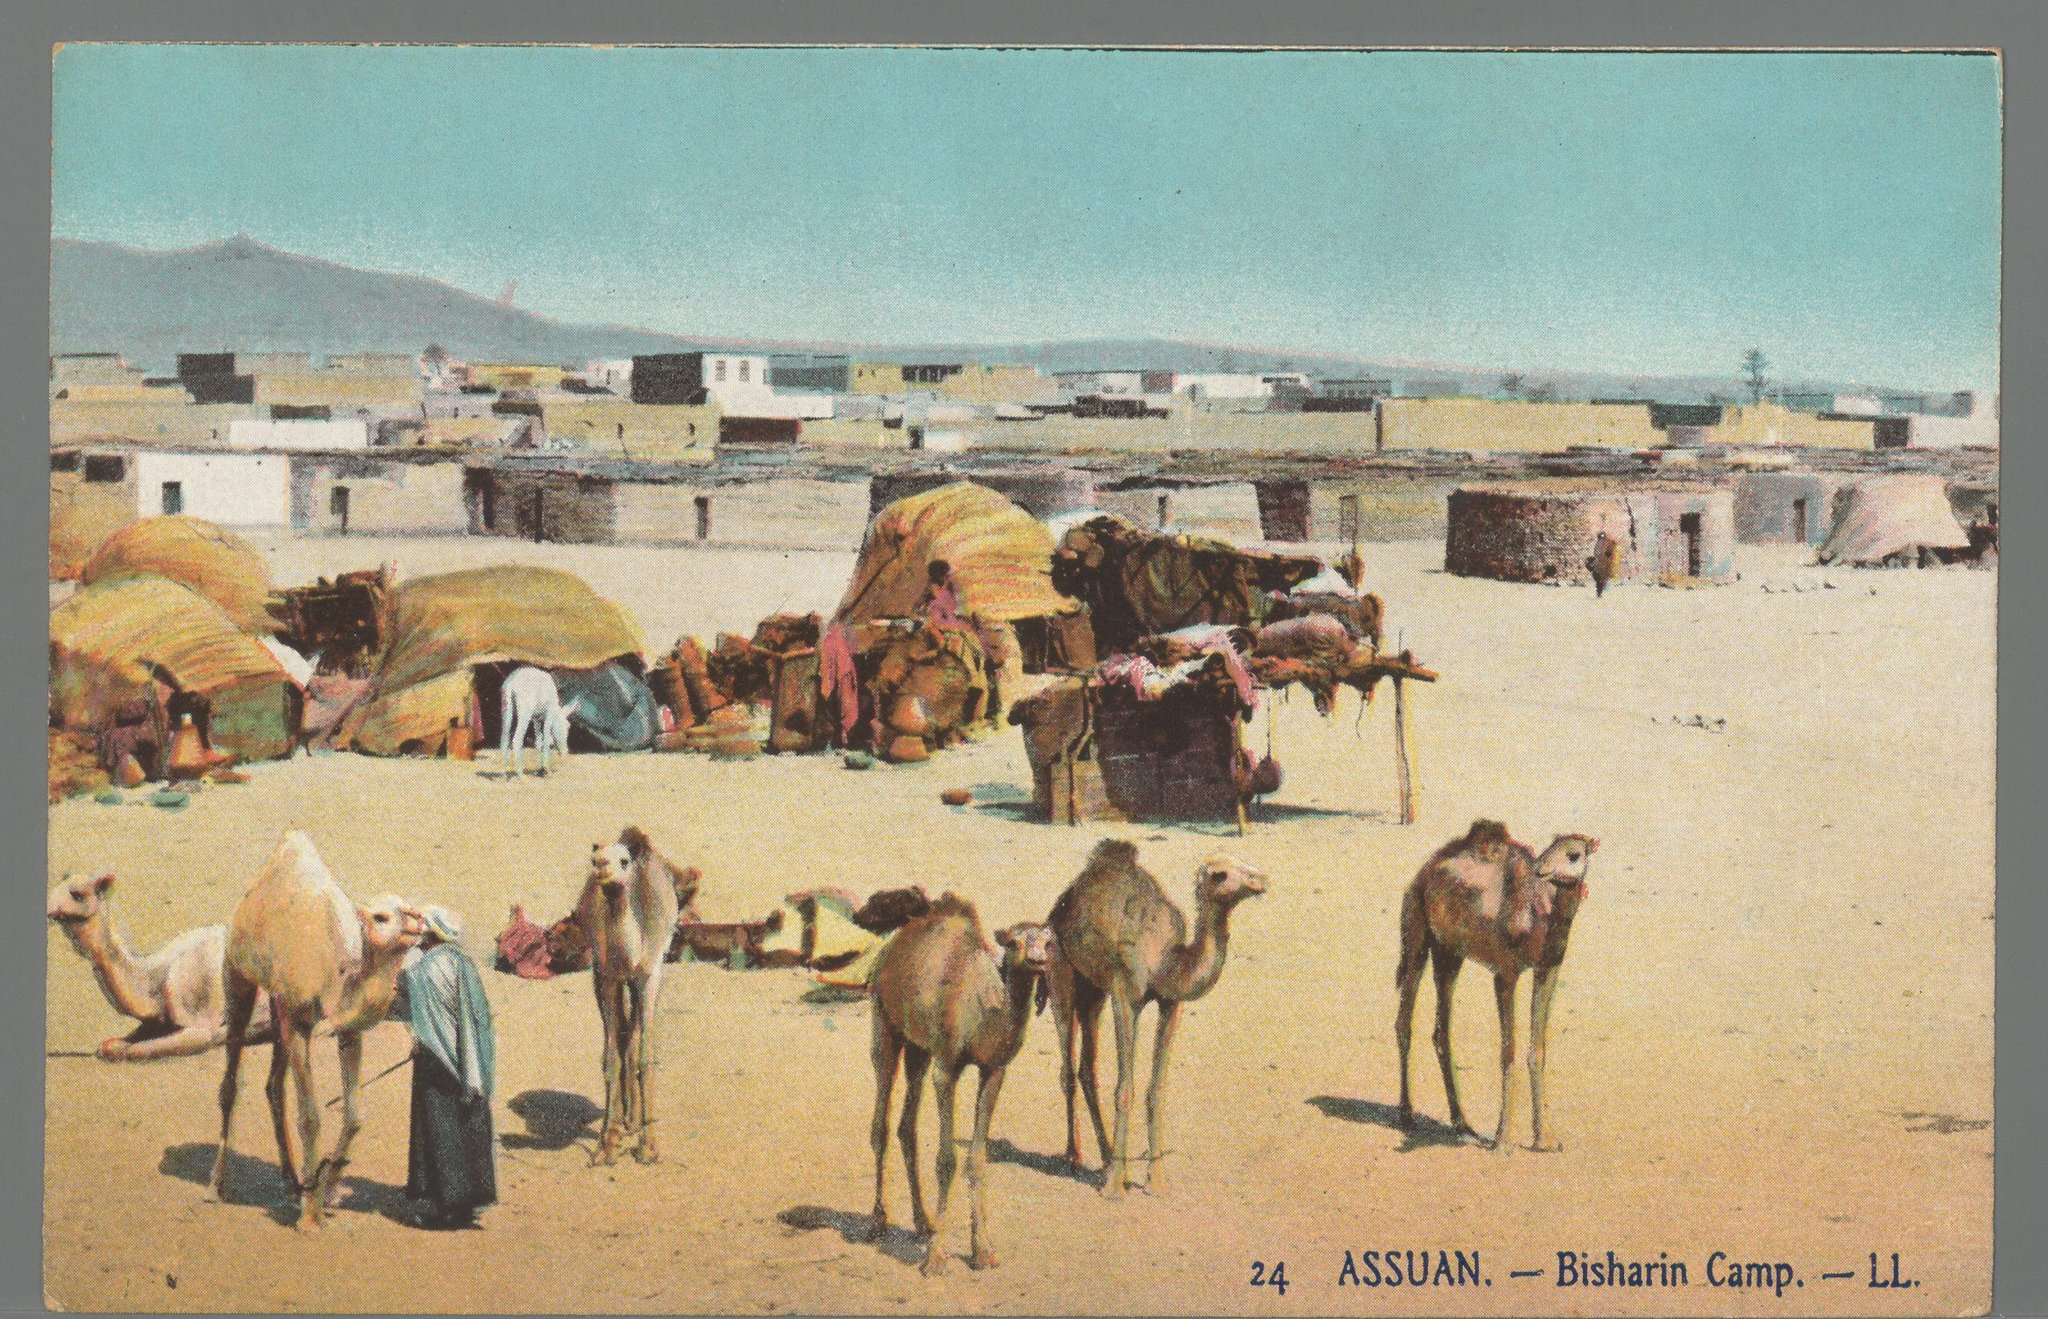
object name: photomechanical print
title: Assuan - Bisharin Camp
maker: Anonymous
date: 1907-1930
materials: cardboard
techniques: lithograph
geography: paris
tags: hoofed animals: dromedary, desert, tent-camp